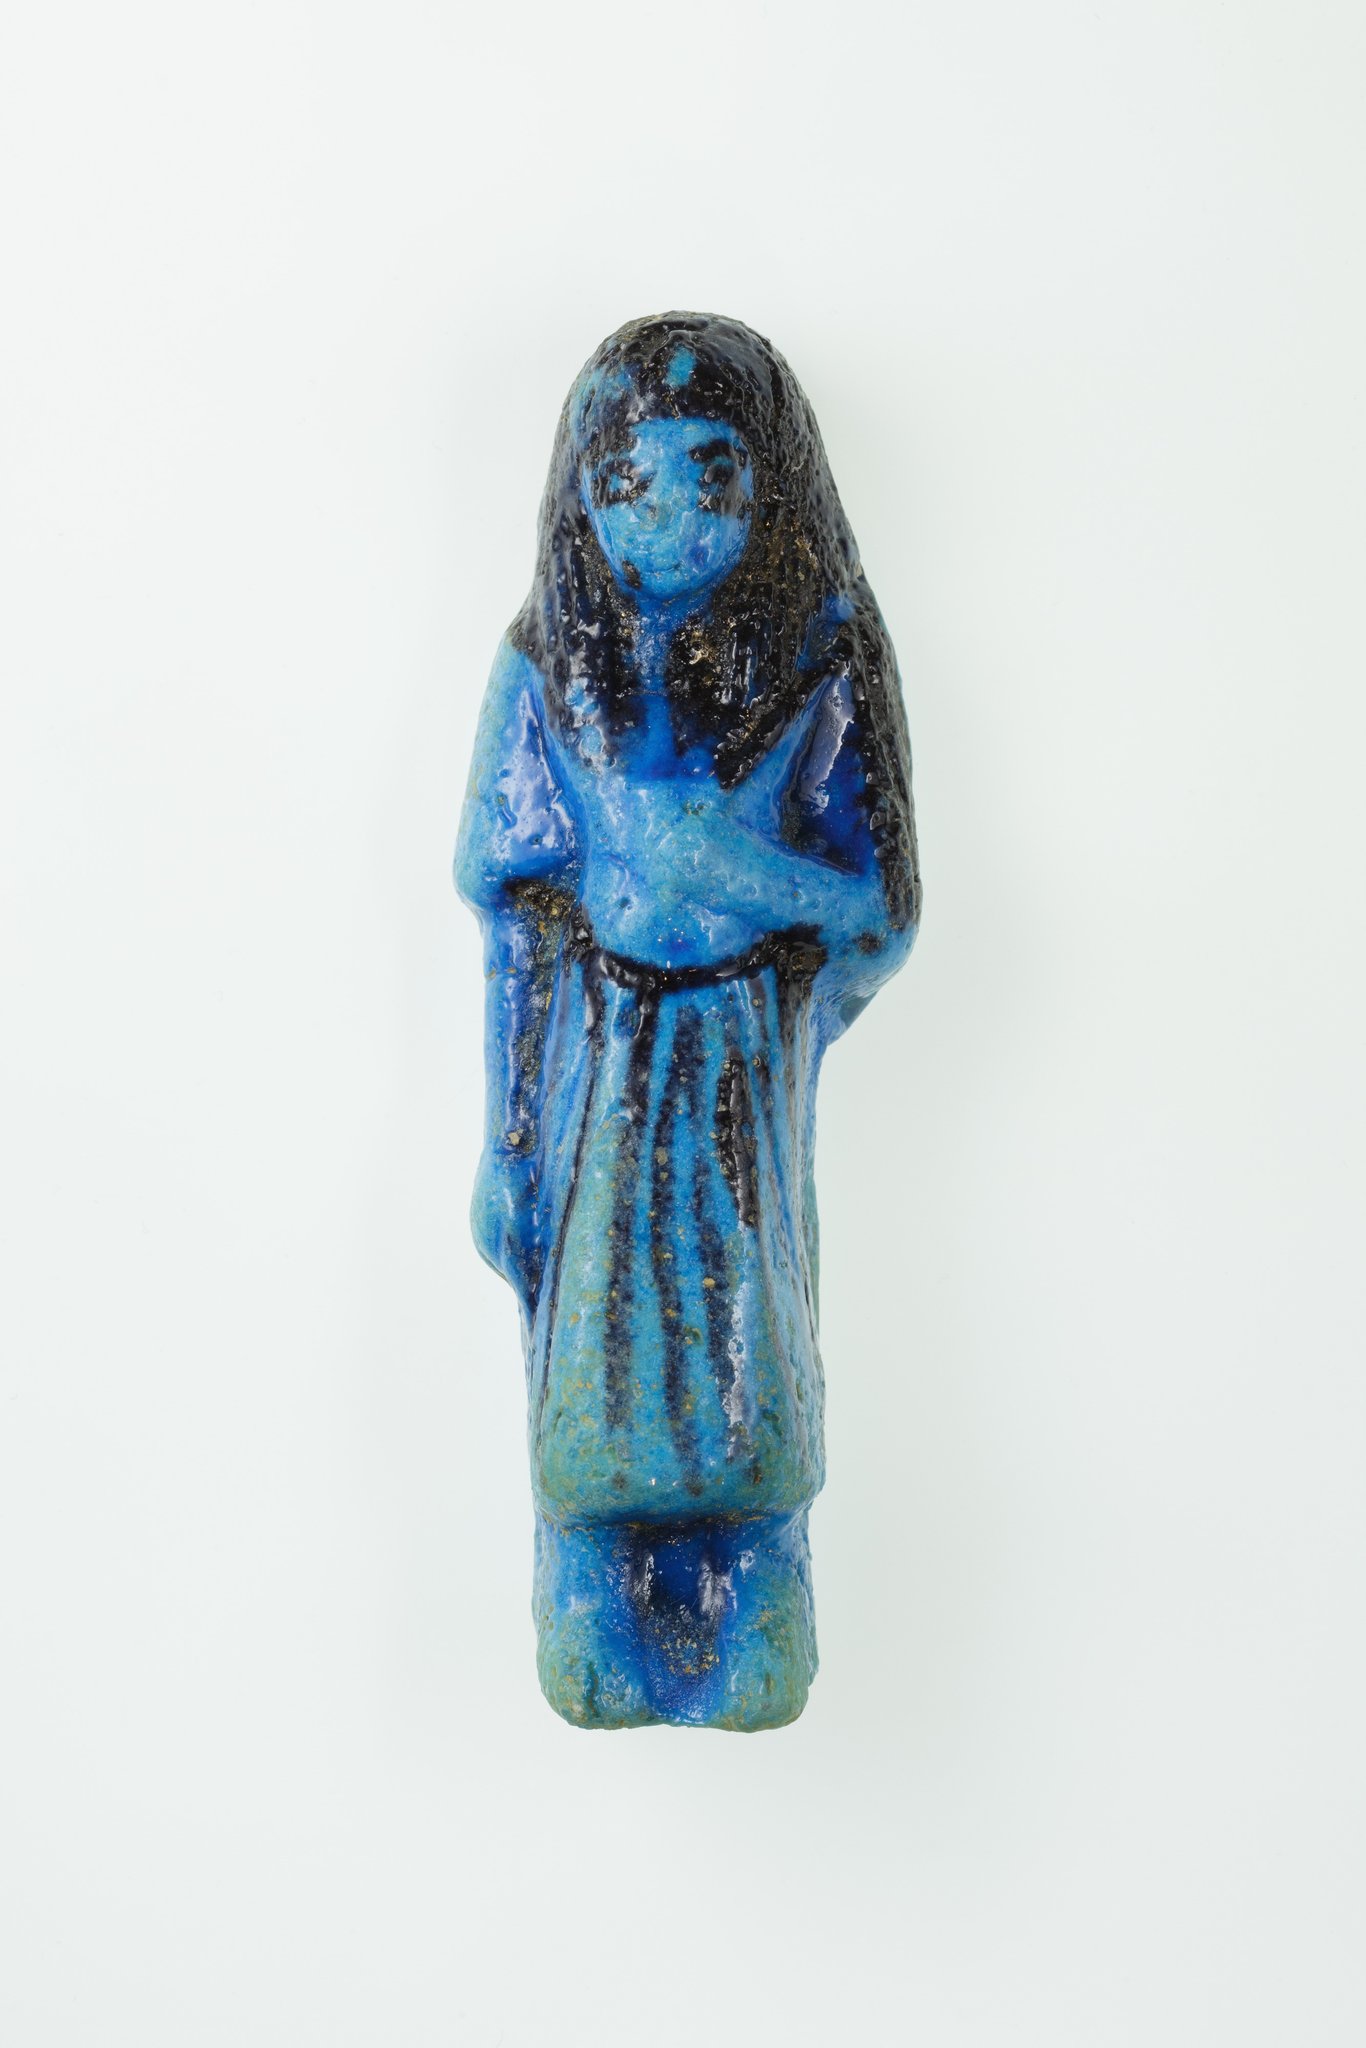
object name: shabti, overseer, nauny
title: Overseer Shabti of Nauny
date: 1050 BCE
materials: faience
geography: egypt